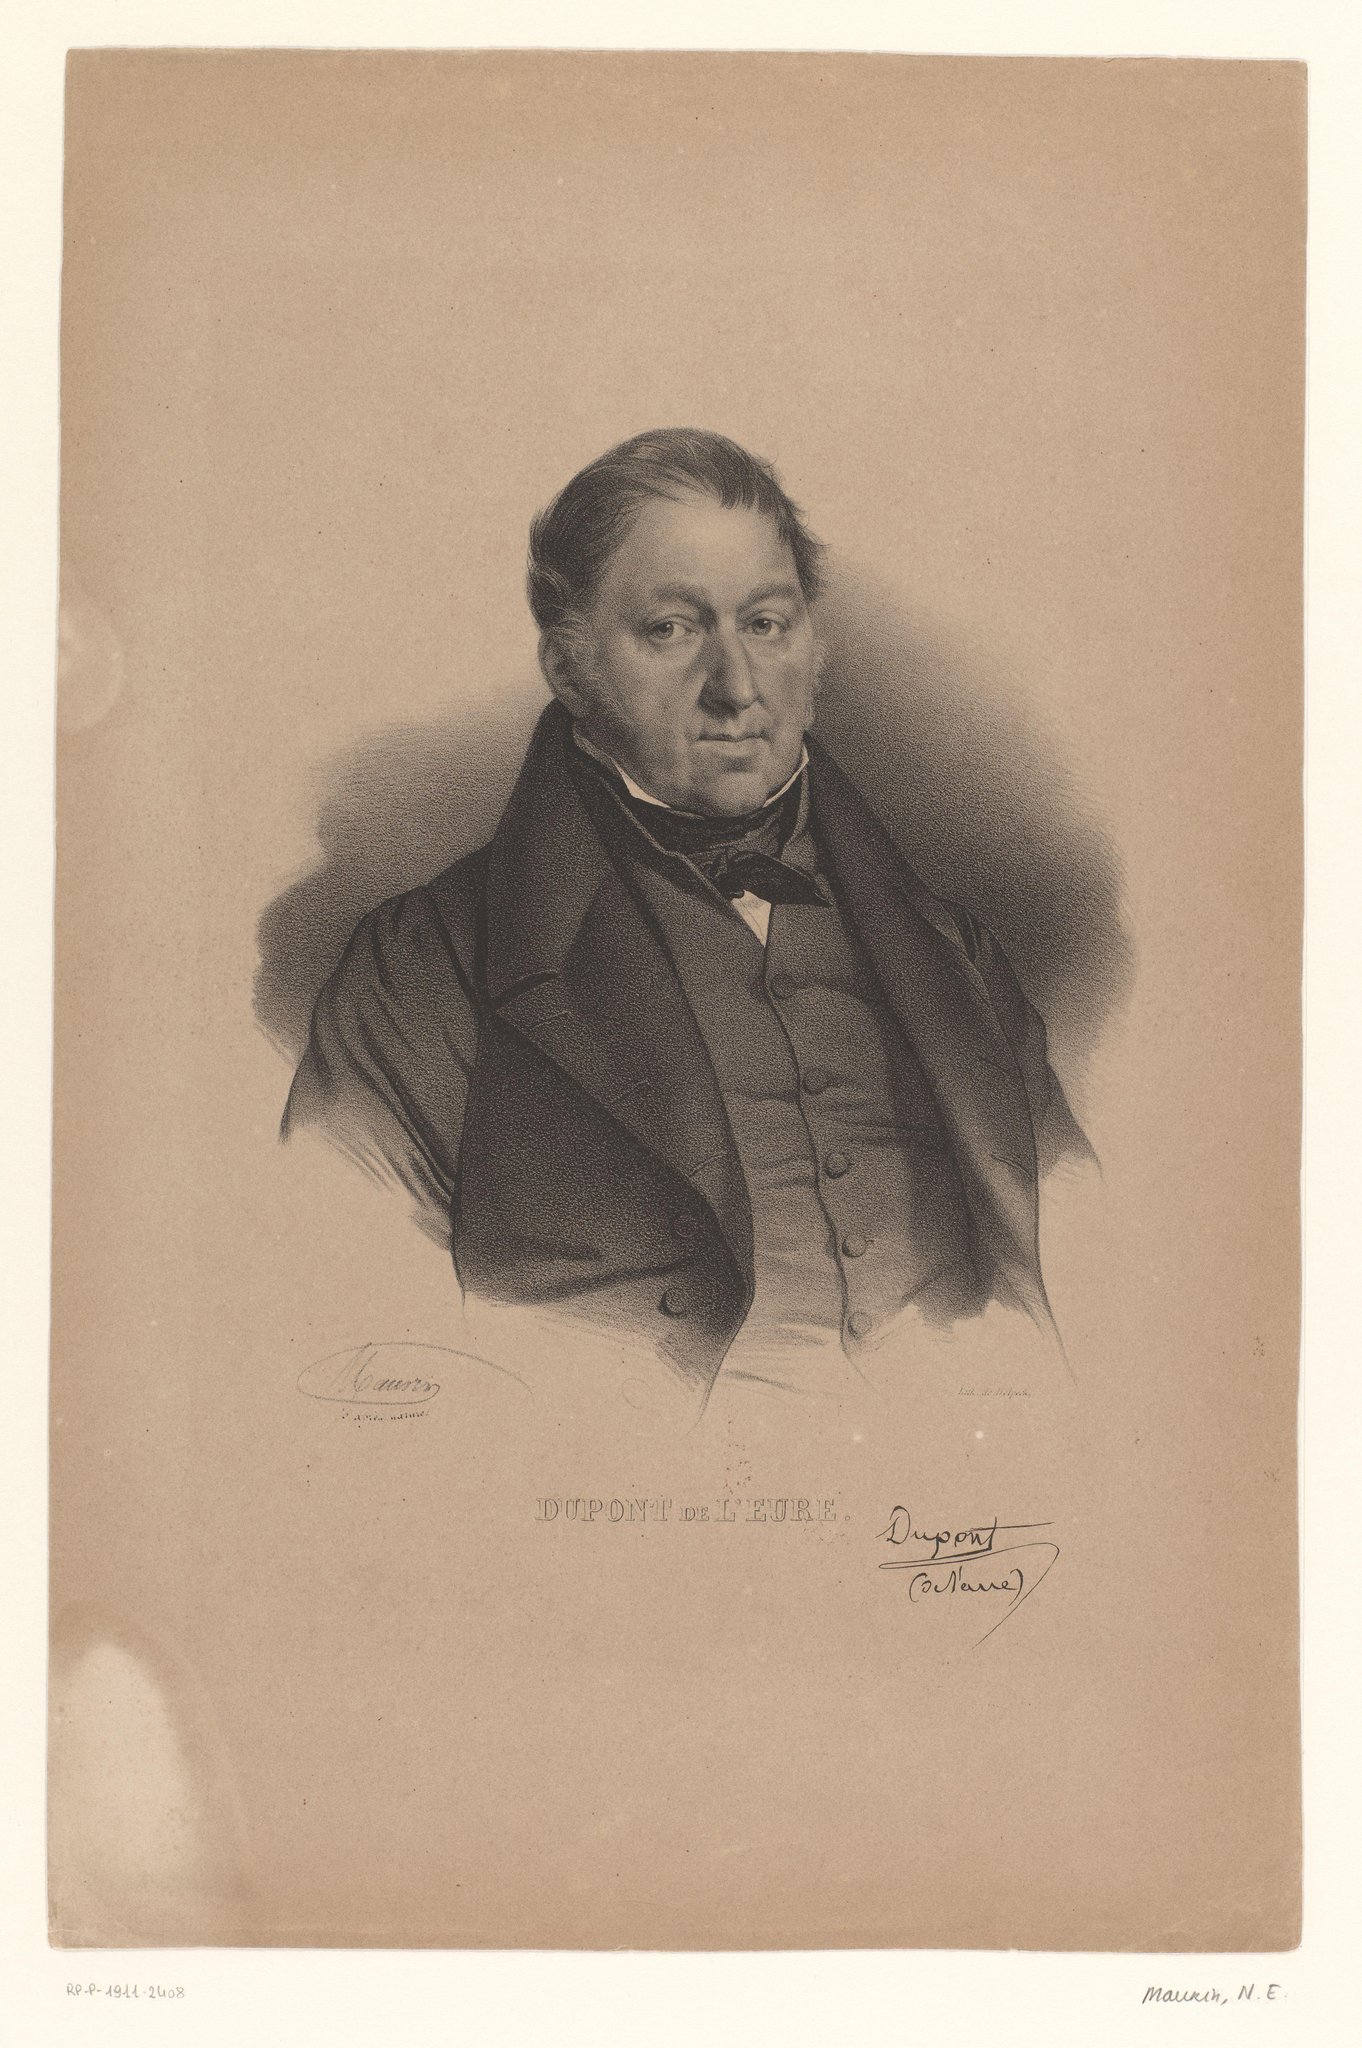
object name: print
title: Dupont de L'Eure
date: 1825-1842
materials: paper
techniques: lithograph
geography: paris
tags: politician, historical persons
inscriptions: collector's mark: Lugt 2228